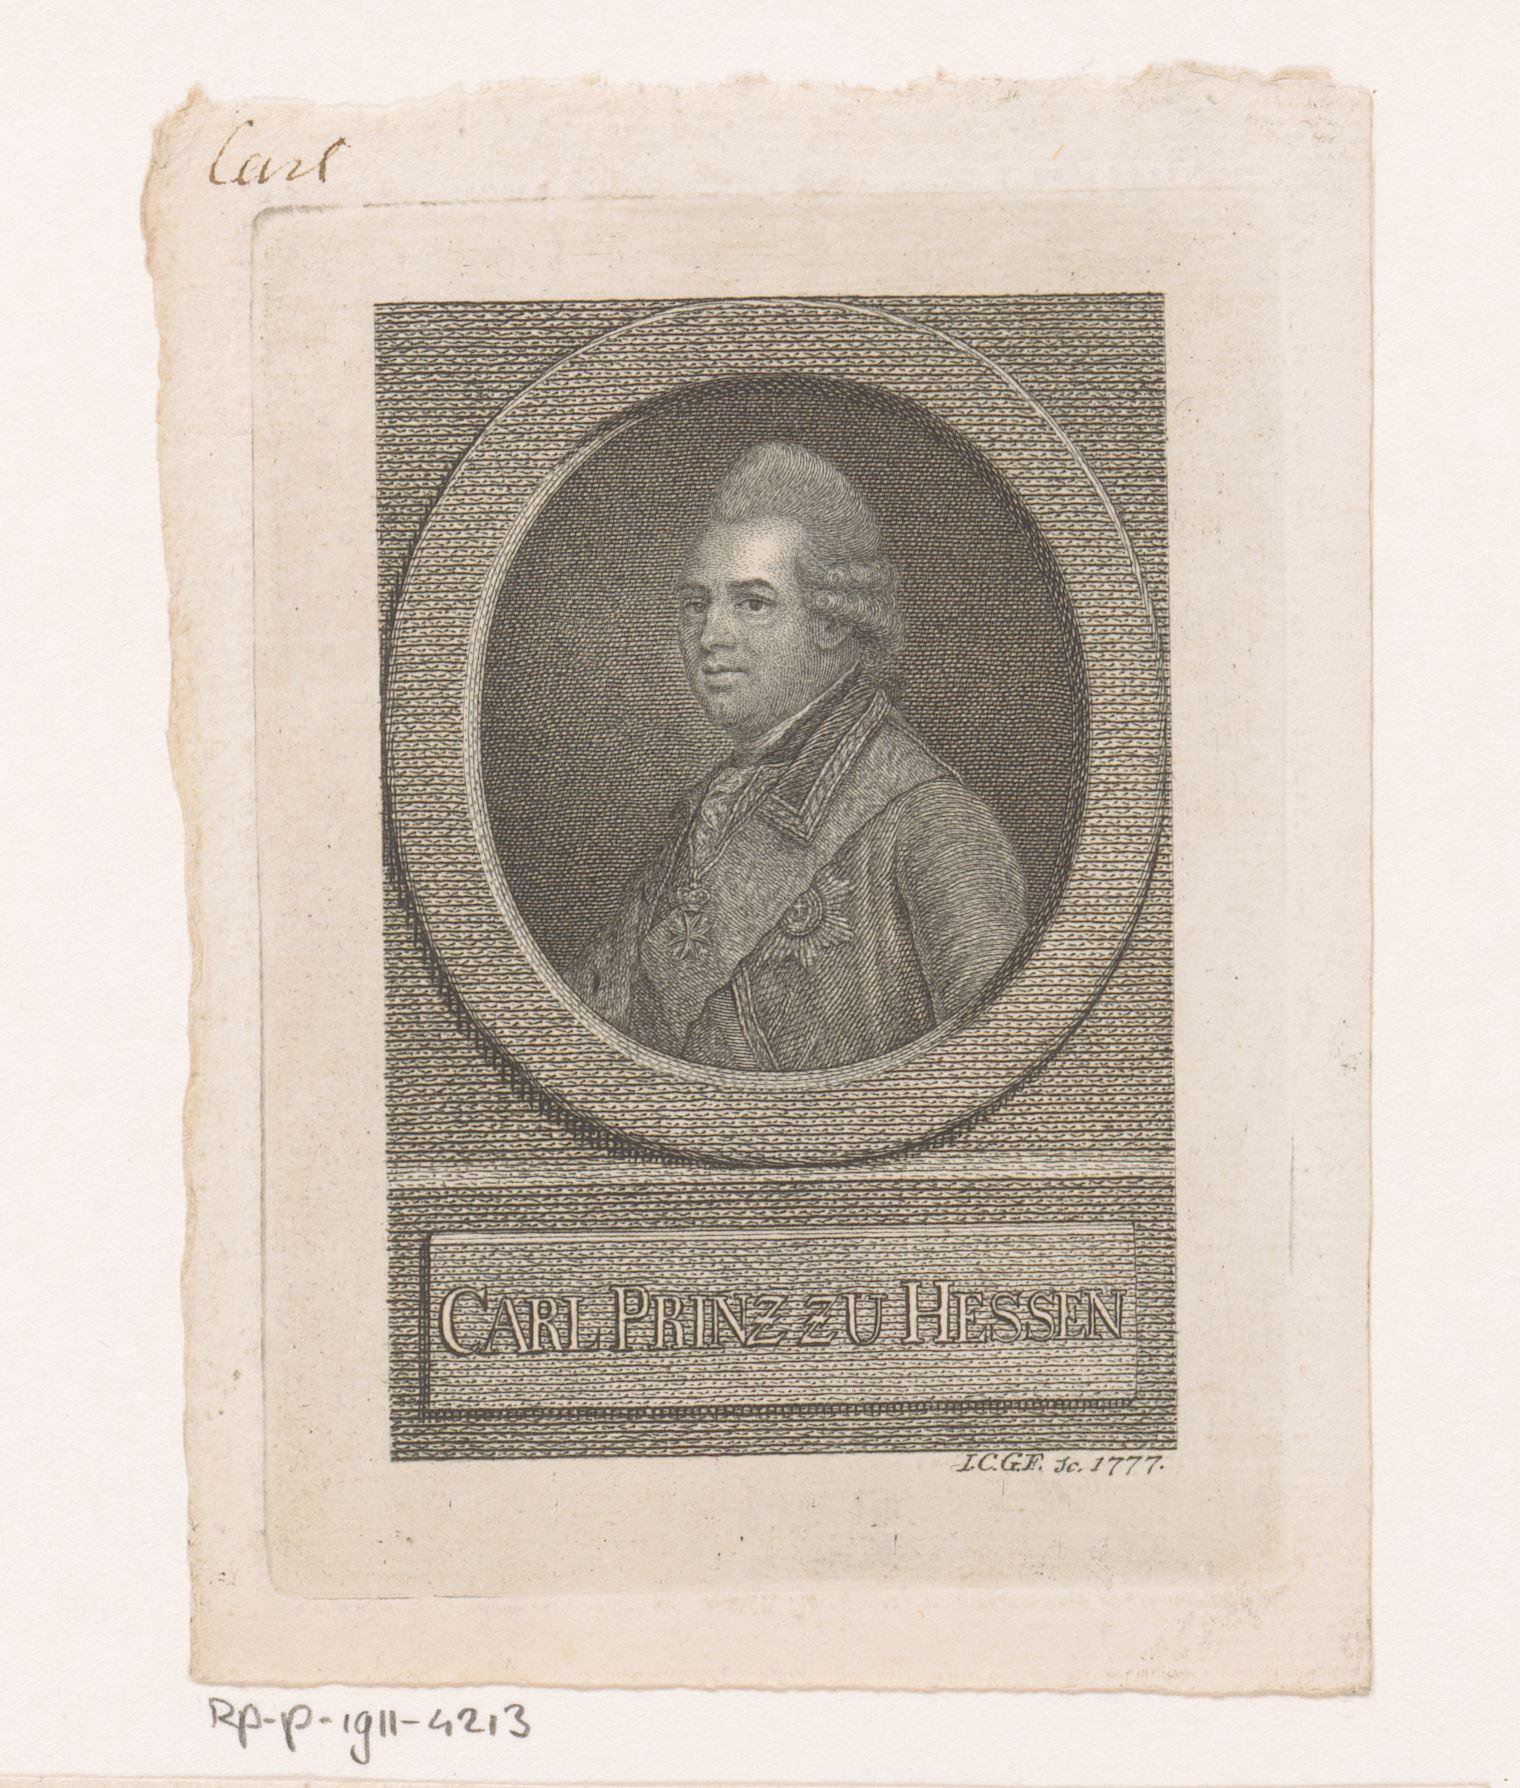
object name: print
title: Portret van Karl von Hessen-Kassel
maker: johann christian gottfried fritzsch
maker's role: print maker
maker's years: 1720-1802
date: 1777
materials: paper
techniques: engraving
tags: knighthood order, historical persons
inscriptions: collector's mark: Lugt 2228